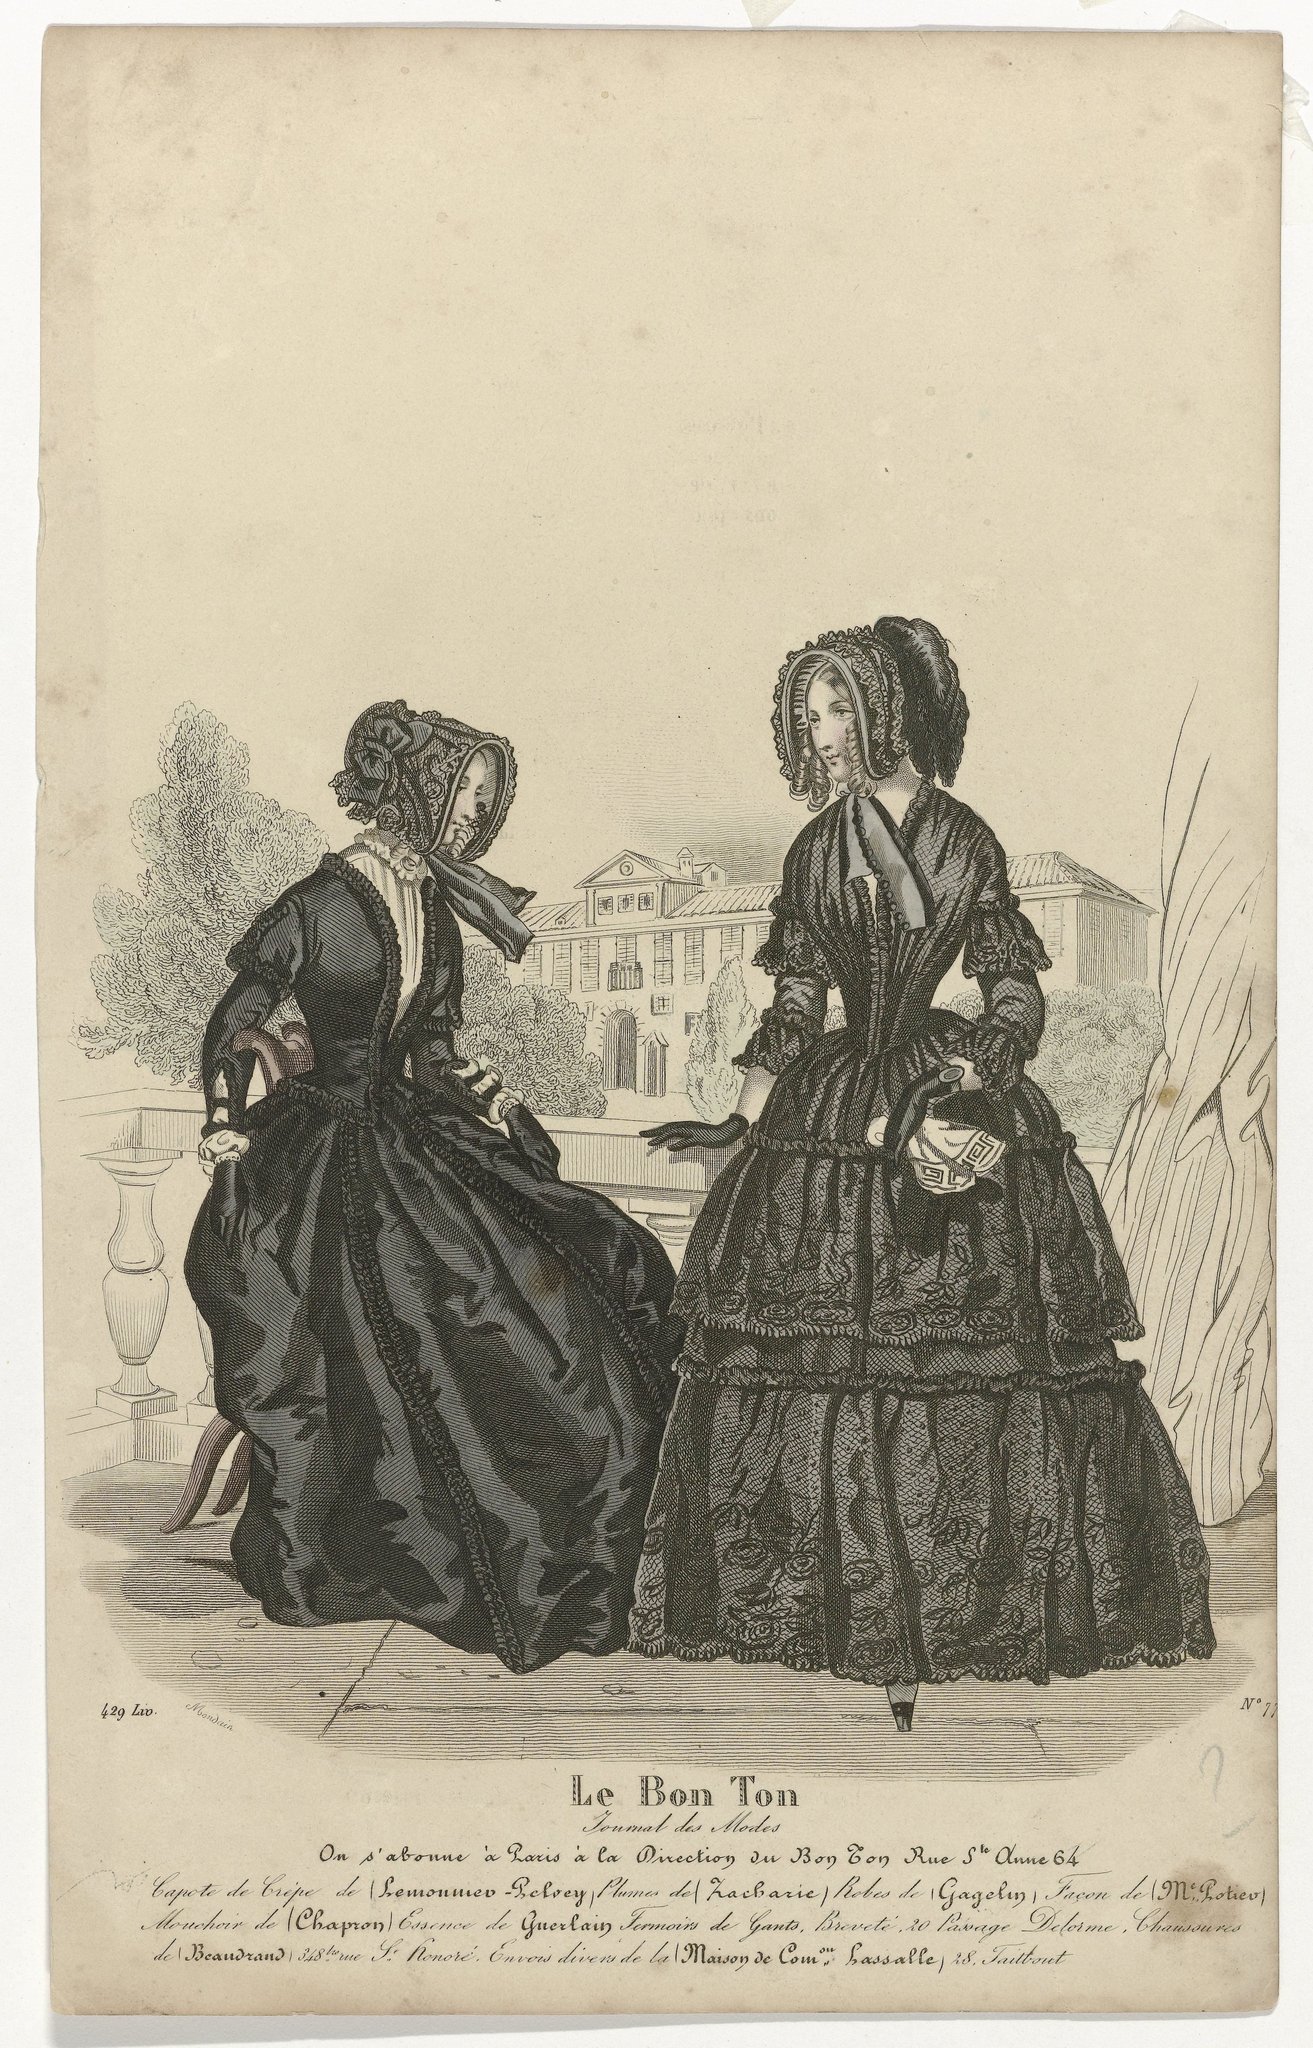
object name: fashion print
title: Le Bon Ton, 8 juillet 1844, 429 Liv. No. 774 : Capote de Crép (...)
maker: eugène mondain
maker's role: print maker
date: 1844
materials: paper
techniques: engraving, hand coloring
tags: handkerchief (+ women's clothes), head-gear (capote) (+ women's clothes), fashion plates, shoes, sandals (+ women's clothes), gloves, mittens, etc. (+ women's clothes), dress, gown (+ women's clothes), mourning dress, neck-gear ~ clothing (+ women's clothes), bracelet, wristlet (+ women's clothes)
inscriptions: address: ‘On s'abonne à Paris la Direction du Bon Ton Rue Ste Anne 64’, title: ‘Le Bon Ton / Journal des Modes’, caption: ‘Capote de Crépe de (Lemonner- Pelvey)Plumes de (Zacharie) Robes de (Gagelin) Façon de (M"e Potiev) Mouchoir de (Chapron) Essence de Guerlain Fermoirs de Gants, Breveté, 20 Passage Delorme, Chaussures de (Beaudraud) 348"bis rue S"t Honoré, Envois divers de la (Maison de Com"on Lassalle) 28, Taitbout’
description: Twee vrouwen gekleed in rouwkleding, op de achtergrond een landgoed. Volgens het onderschrift: 'capote' van crêpe van Lemonnier-Pelvey. Japonnen voor de rouw van Gagelin, uitgevoerd op de manier van Potiev. Zakdoek van Chapron. Hieronder enkele regels reclametekst voor verschillende producten. Prent uit het modetijdschrift Le Bon Ton (1834-1884).